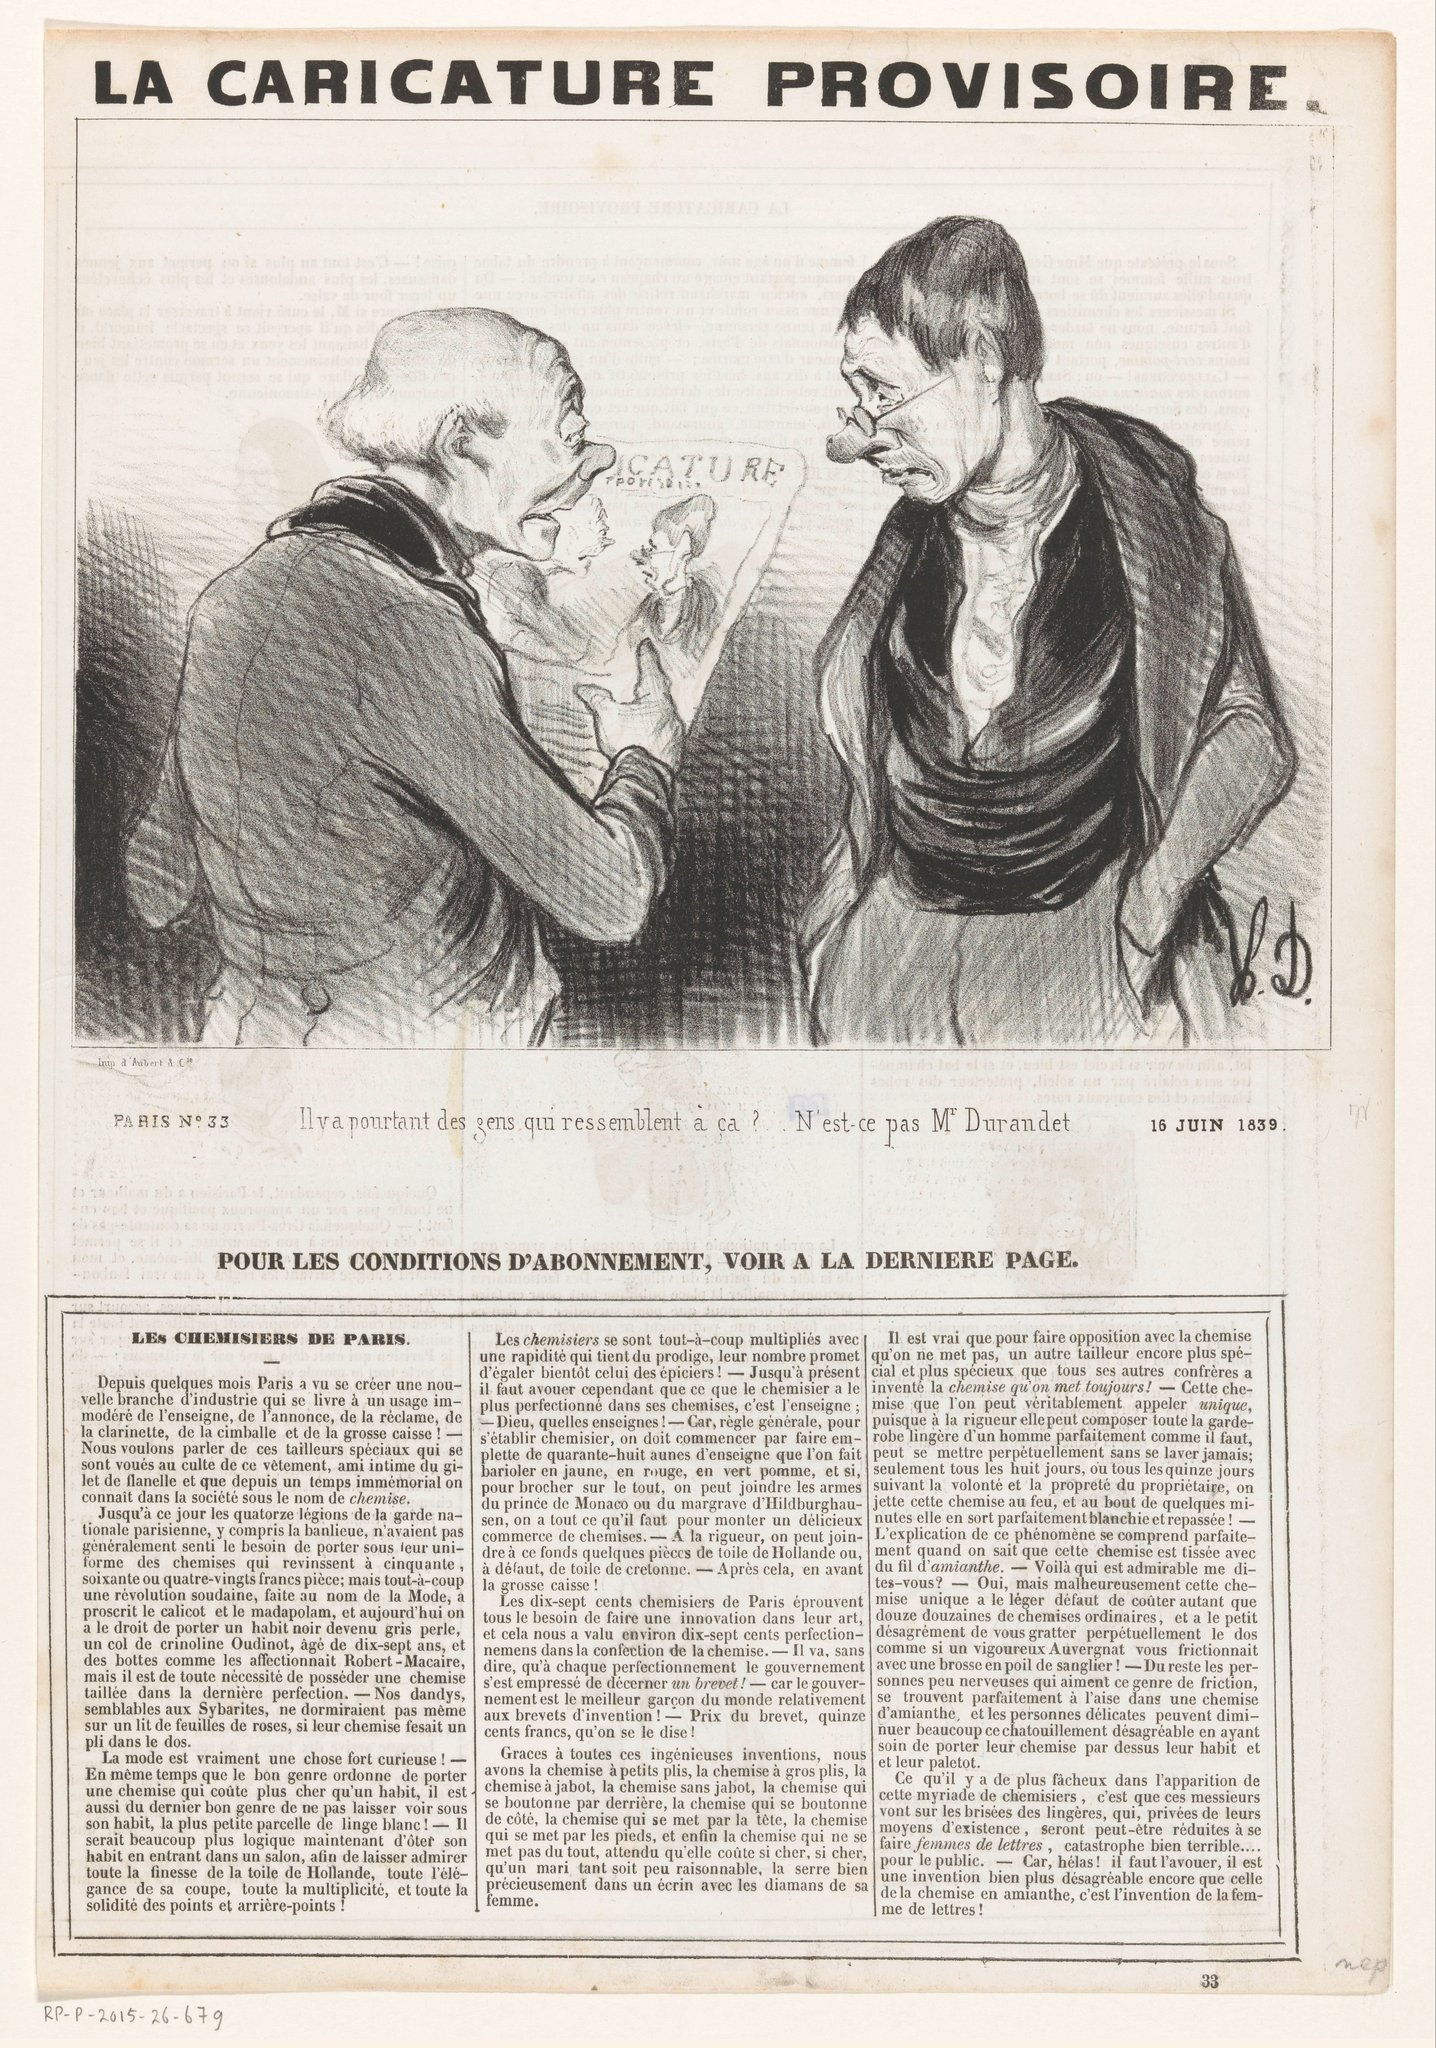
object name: illustration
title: Twee mannen bespreken een tijdschrift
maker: honoré daumier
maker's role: draughtsman, painter, print maker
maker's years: 1808-1879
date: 1806-1839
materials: paper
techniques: letterpress printing, lithograph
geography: paris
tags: caricatures (human types)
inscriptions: collector's mark: Lugt 2228, collector's mark: Lugt 4780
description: Het betreft een aflevering van La Caricature Provisoire waarop de mannen zelf staan afgebeeld.